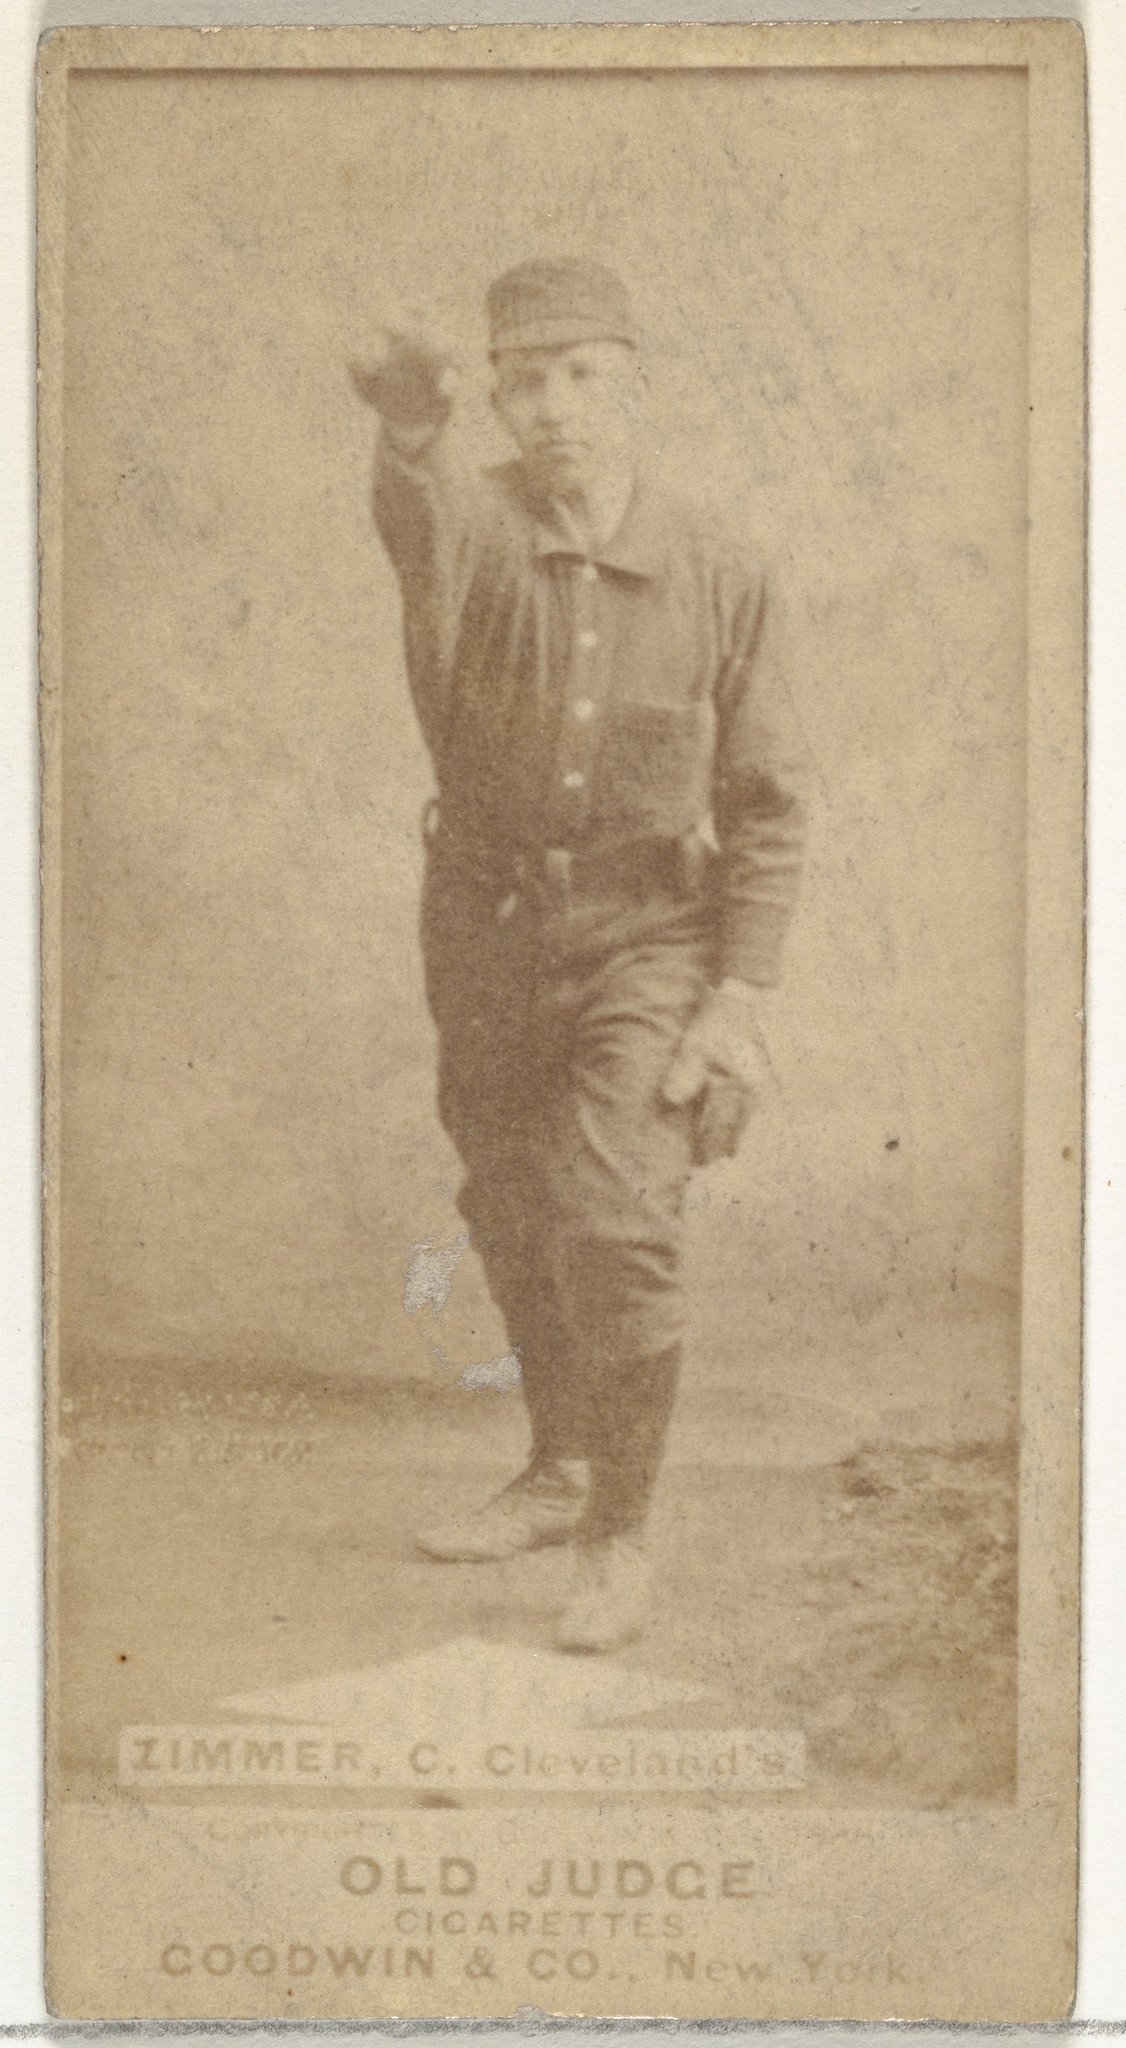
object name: baseball card, photograph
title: Charles Louis "Chief" Zimmer, Catcher, Cleveland, from the Old Judge series (N172) for Old Judge Cigarettes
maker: goodwin & company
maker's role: publisher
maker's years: 1850-1950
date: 1887-1890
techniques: albumen silver print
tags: men,portraits,baseball,athletes